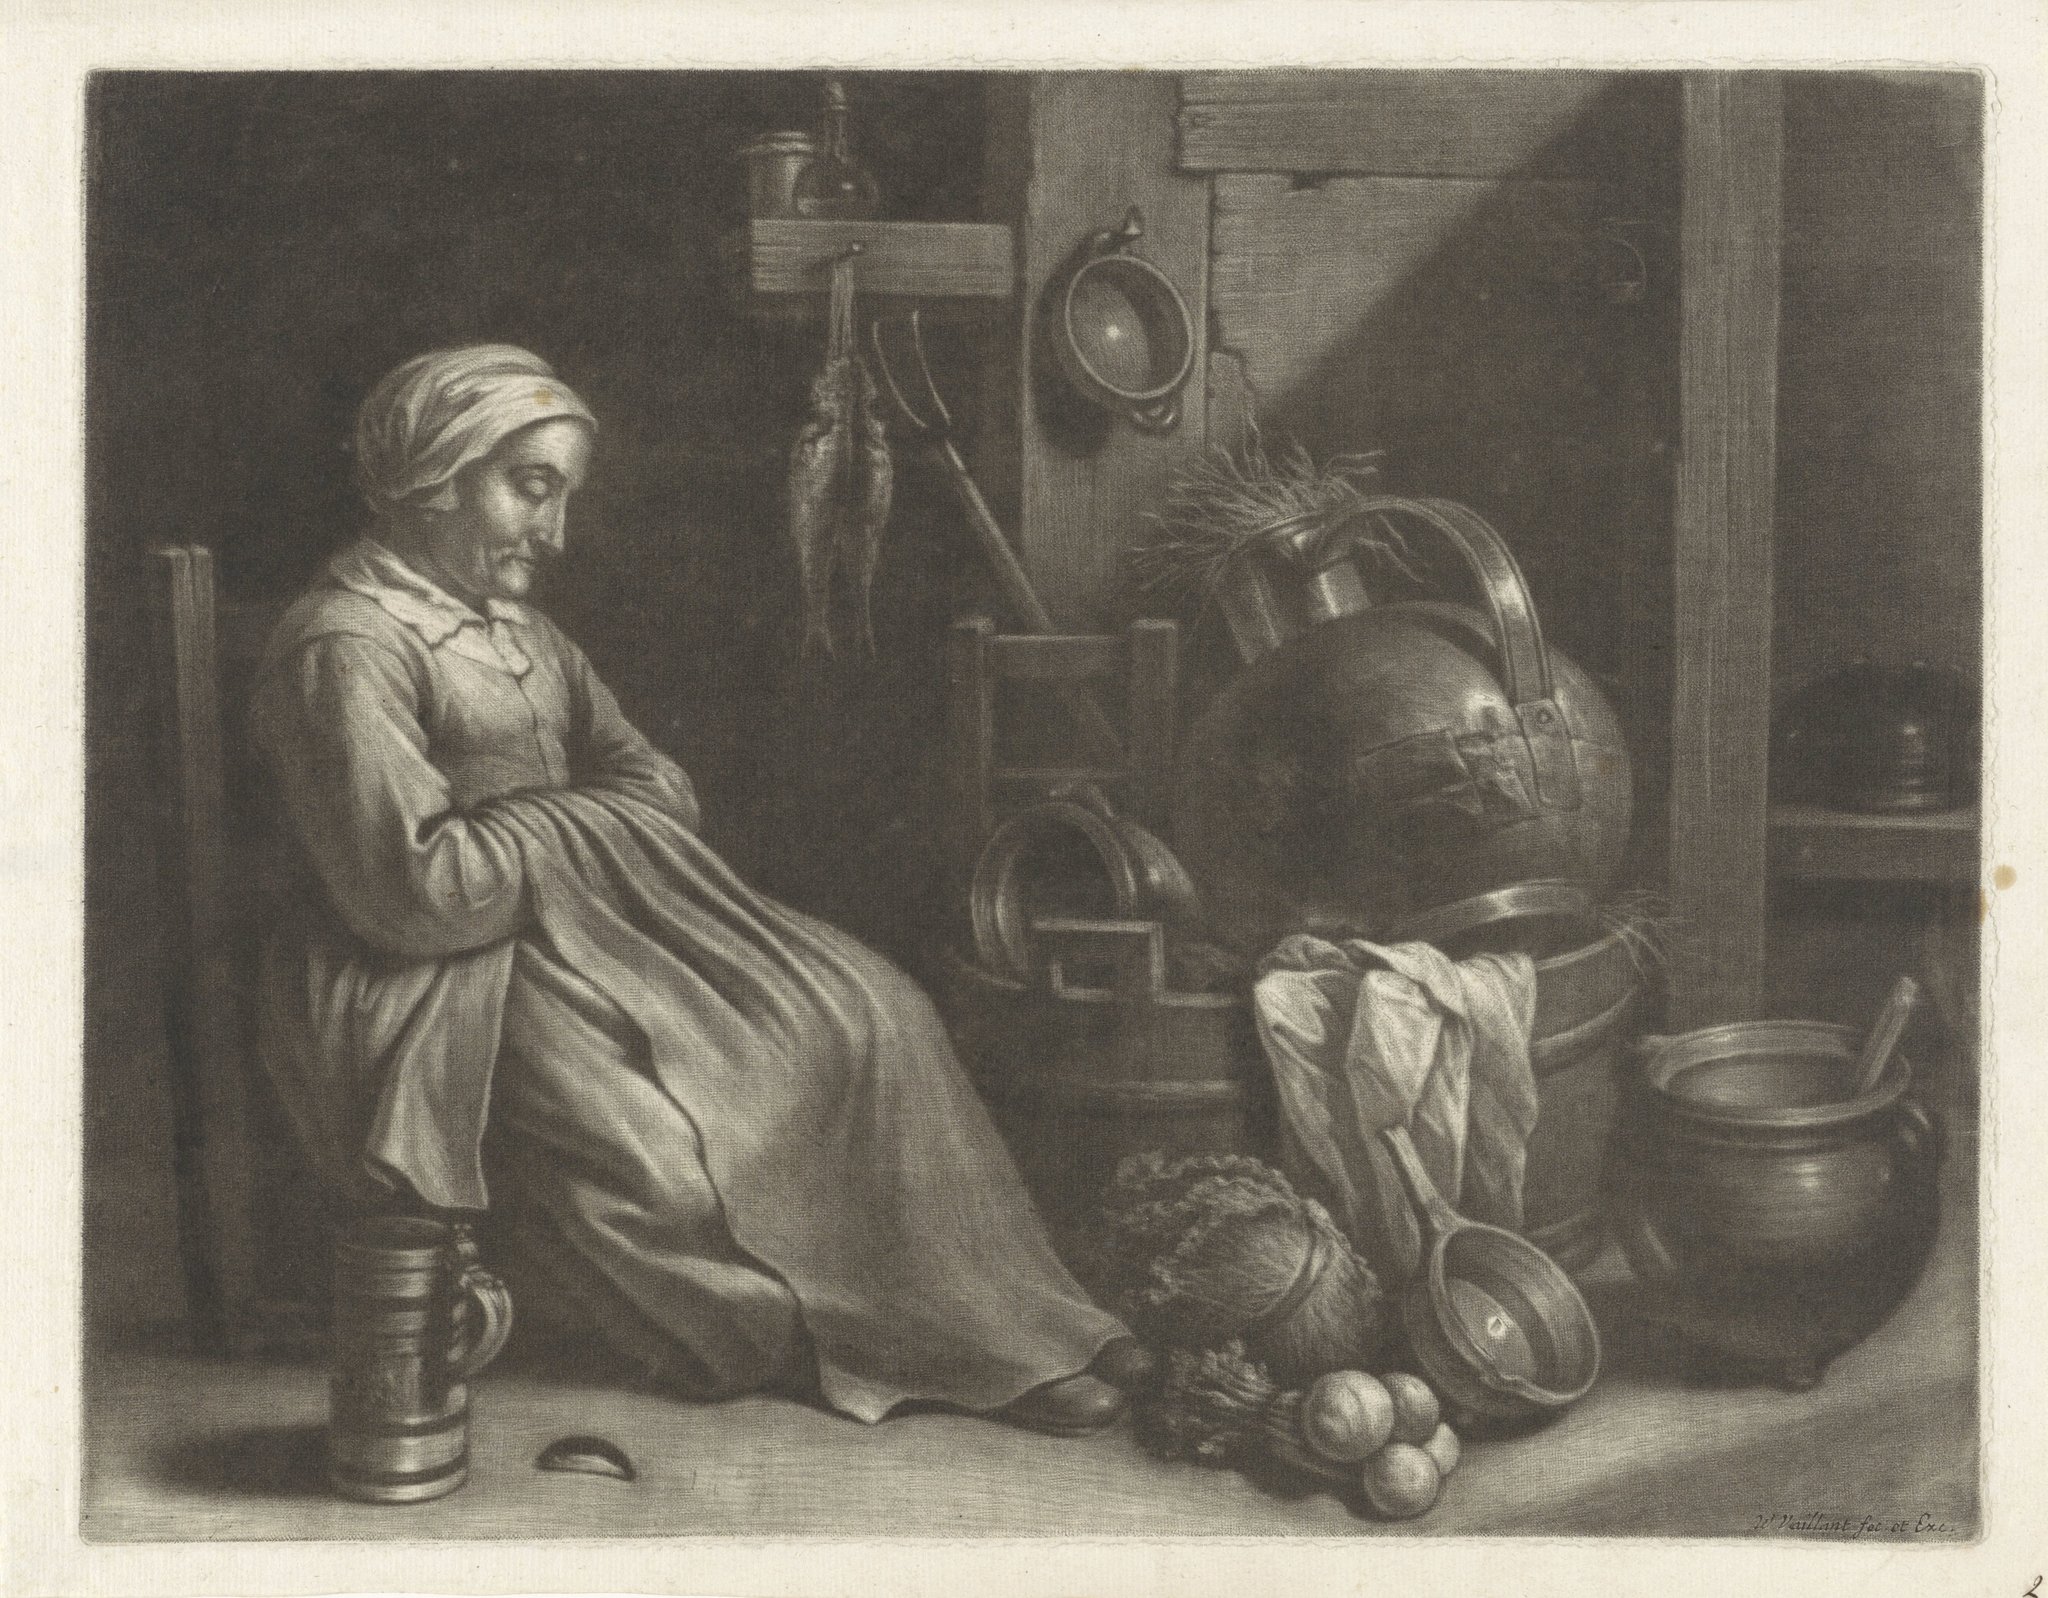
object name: print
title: Slapende dienstmeid in een keuken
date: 1658-1677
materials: paper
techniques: mezzotint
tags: sleeping in chair, old woman, kitchen-interior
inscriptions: collector's mark: Lugt 10, collector's mark: Lugt 11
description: In een keuken zit een oude dienstmeid te slapen op een stoel. Op de grond naast haar staat een pul en voor haar liggen groenten en keukenspullen.